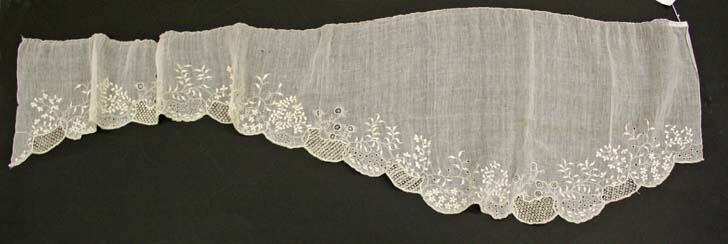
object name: engageantes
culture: british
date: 1765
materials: cotton